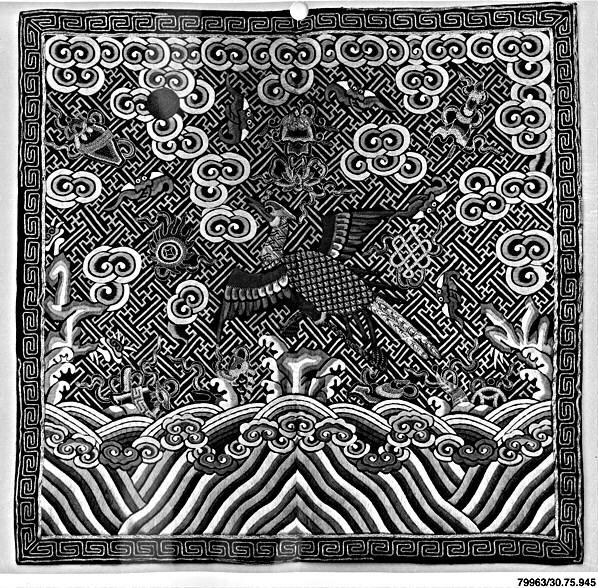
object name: rank badge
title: Rank Badge with Golden Pheasant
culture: chinese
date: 1801-1900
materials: metal thread, silk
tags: bats,pheasants